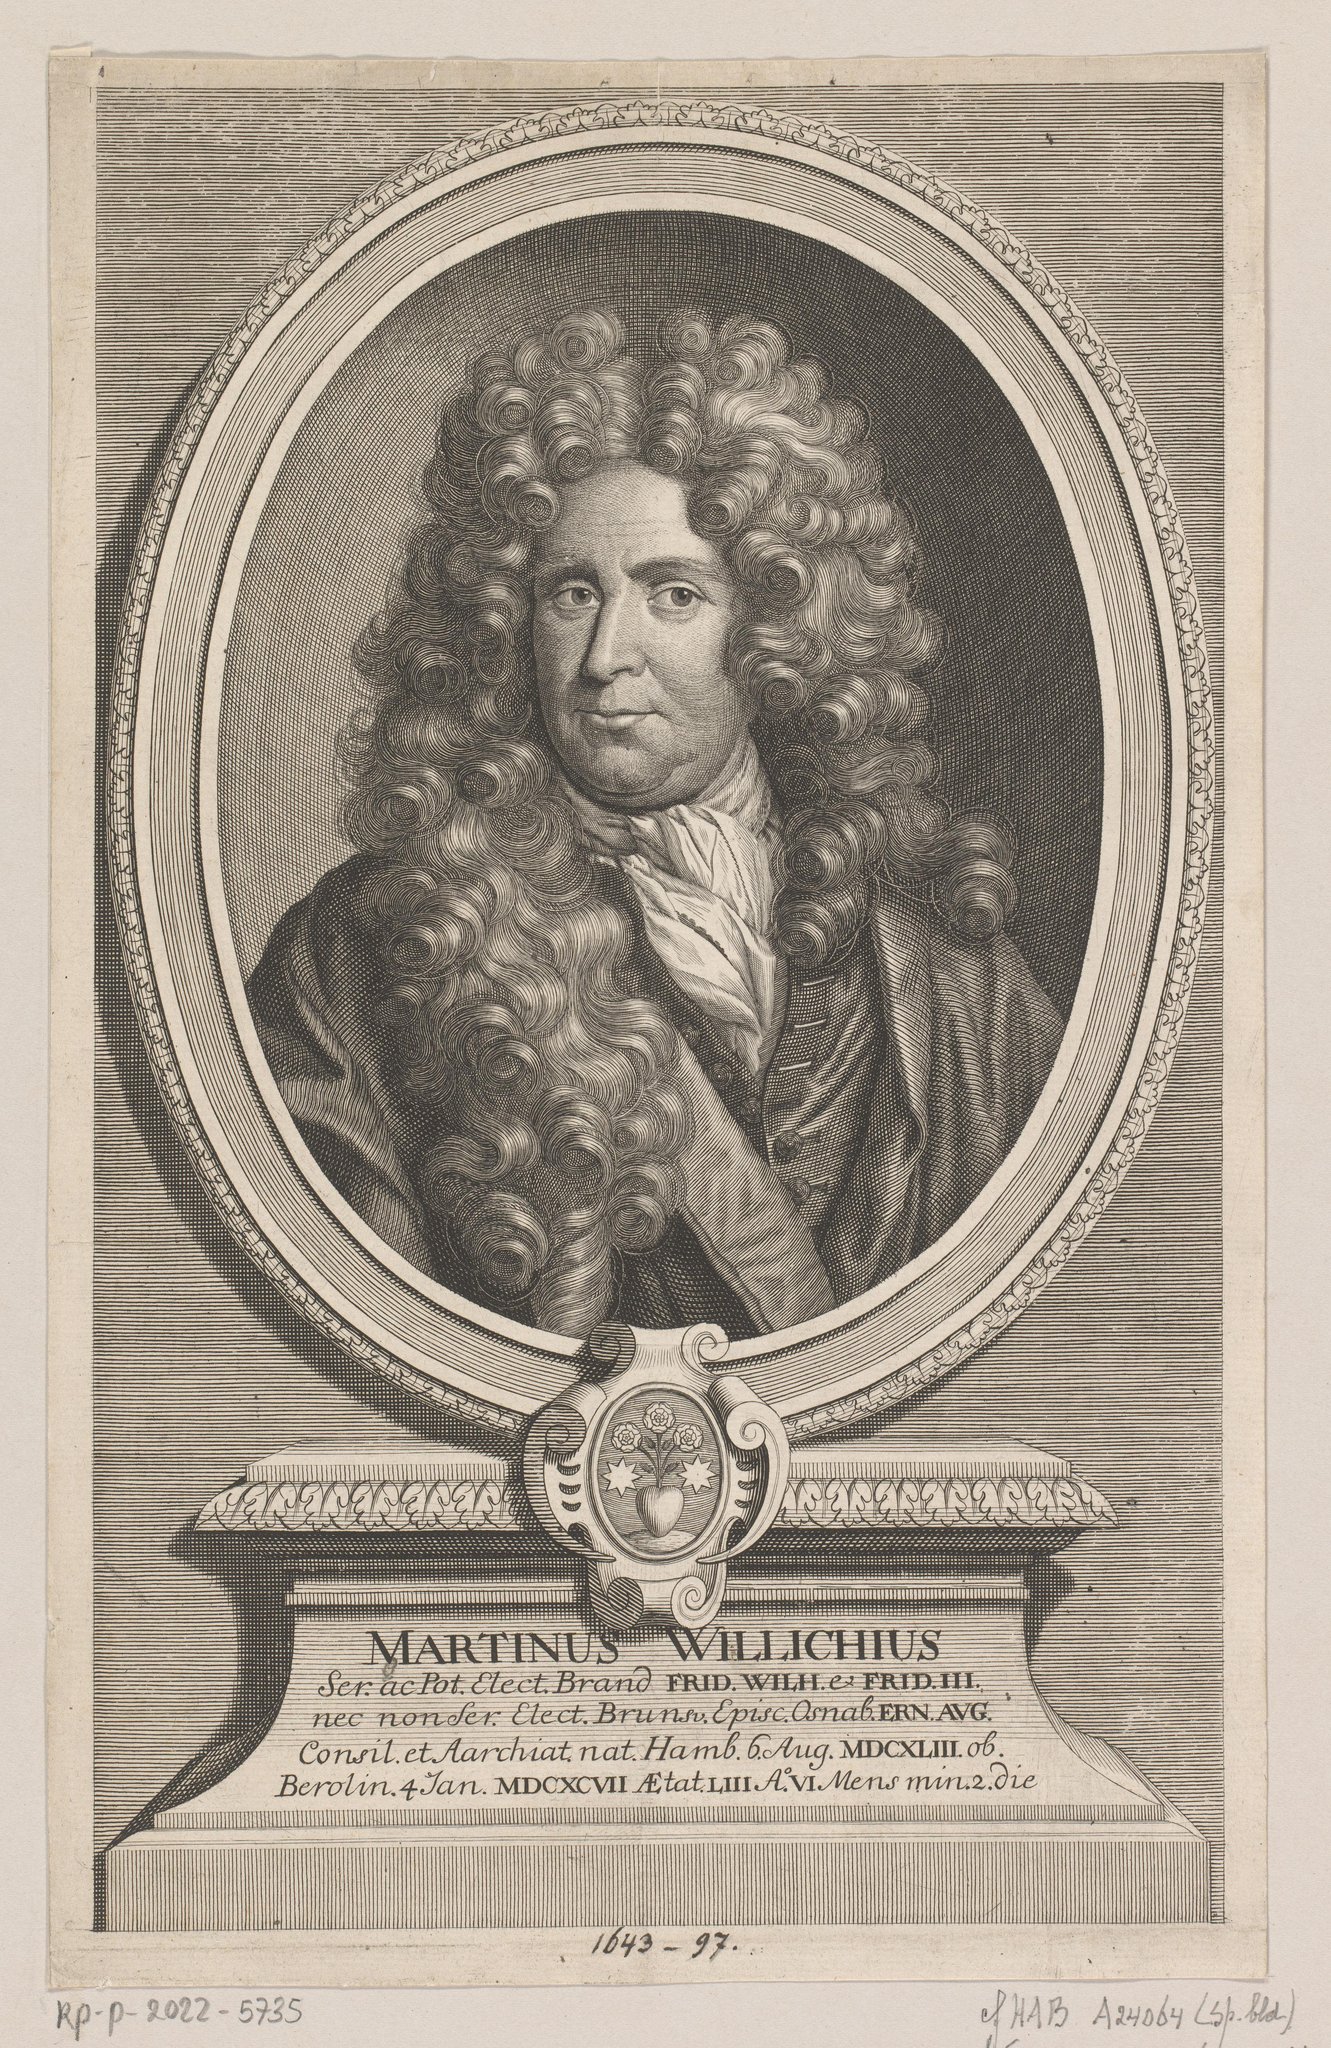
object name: print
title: Portret van Martin Willich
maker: Anonymous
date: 1697-1750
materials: paper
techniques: engraving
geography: berlin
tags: historical persons, physician, doctor (+ portrait of scholar, scientist)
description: Met vierregelig onderschrift in het Latijn.